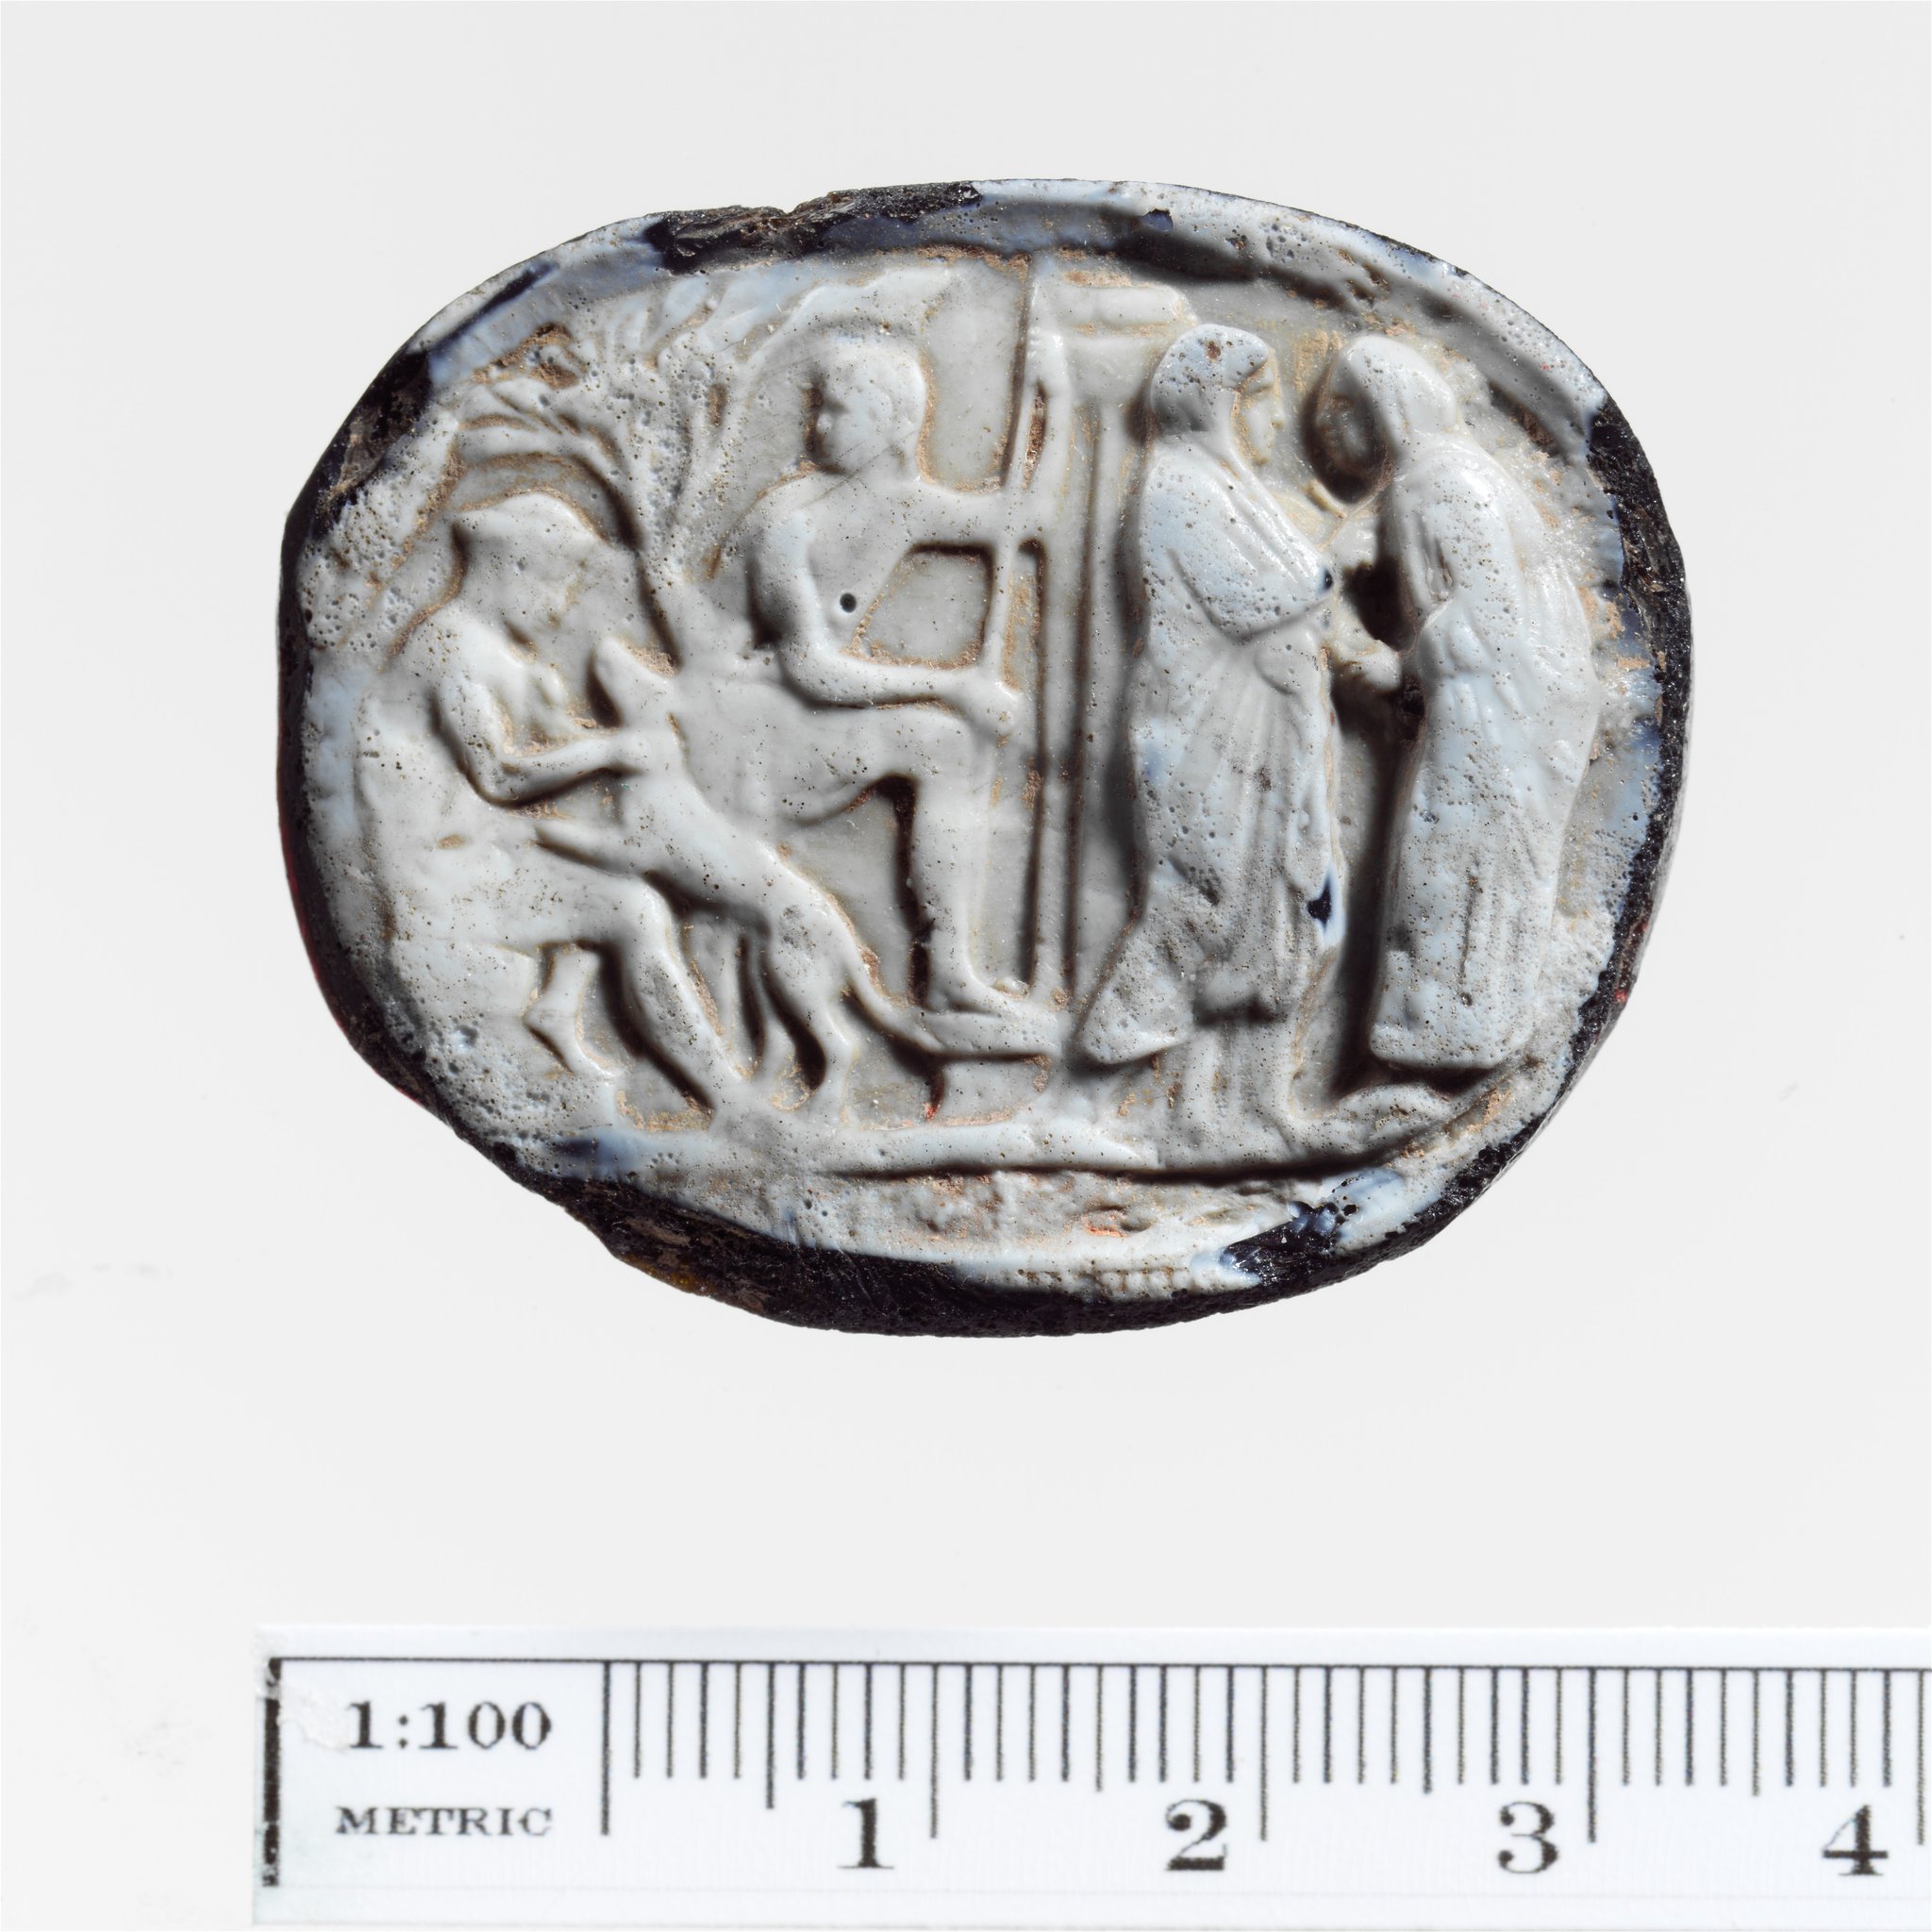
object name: cameo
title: Opaque white on opaque blue glass cameo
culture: roman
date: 100 BCE-300 CE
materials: glass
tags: animals,men,women